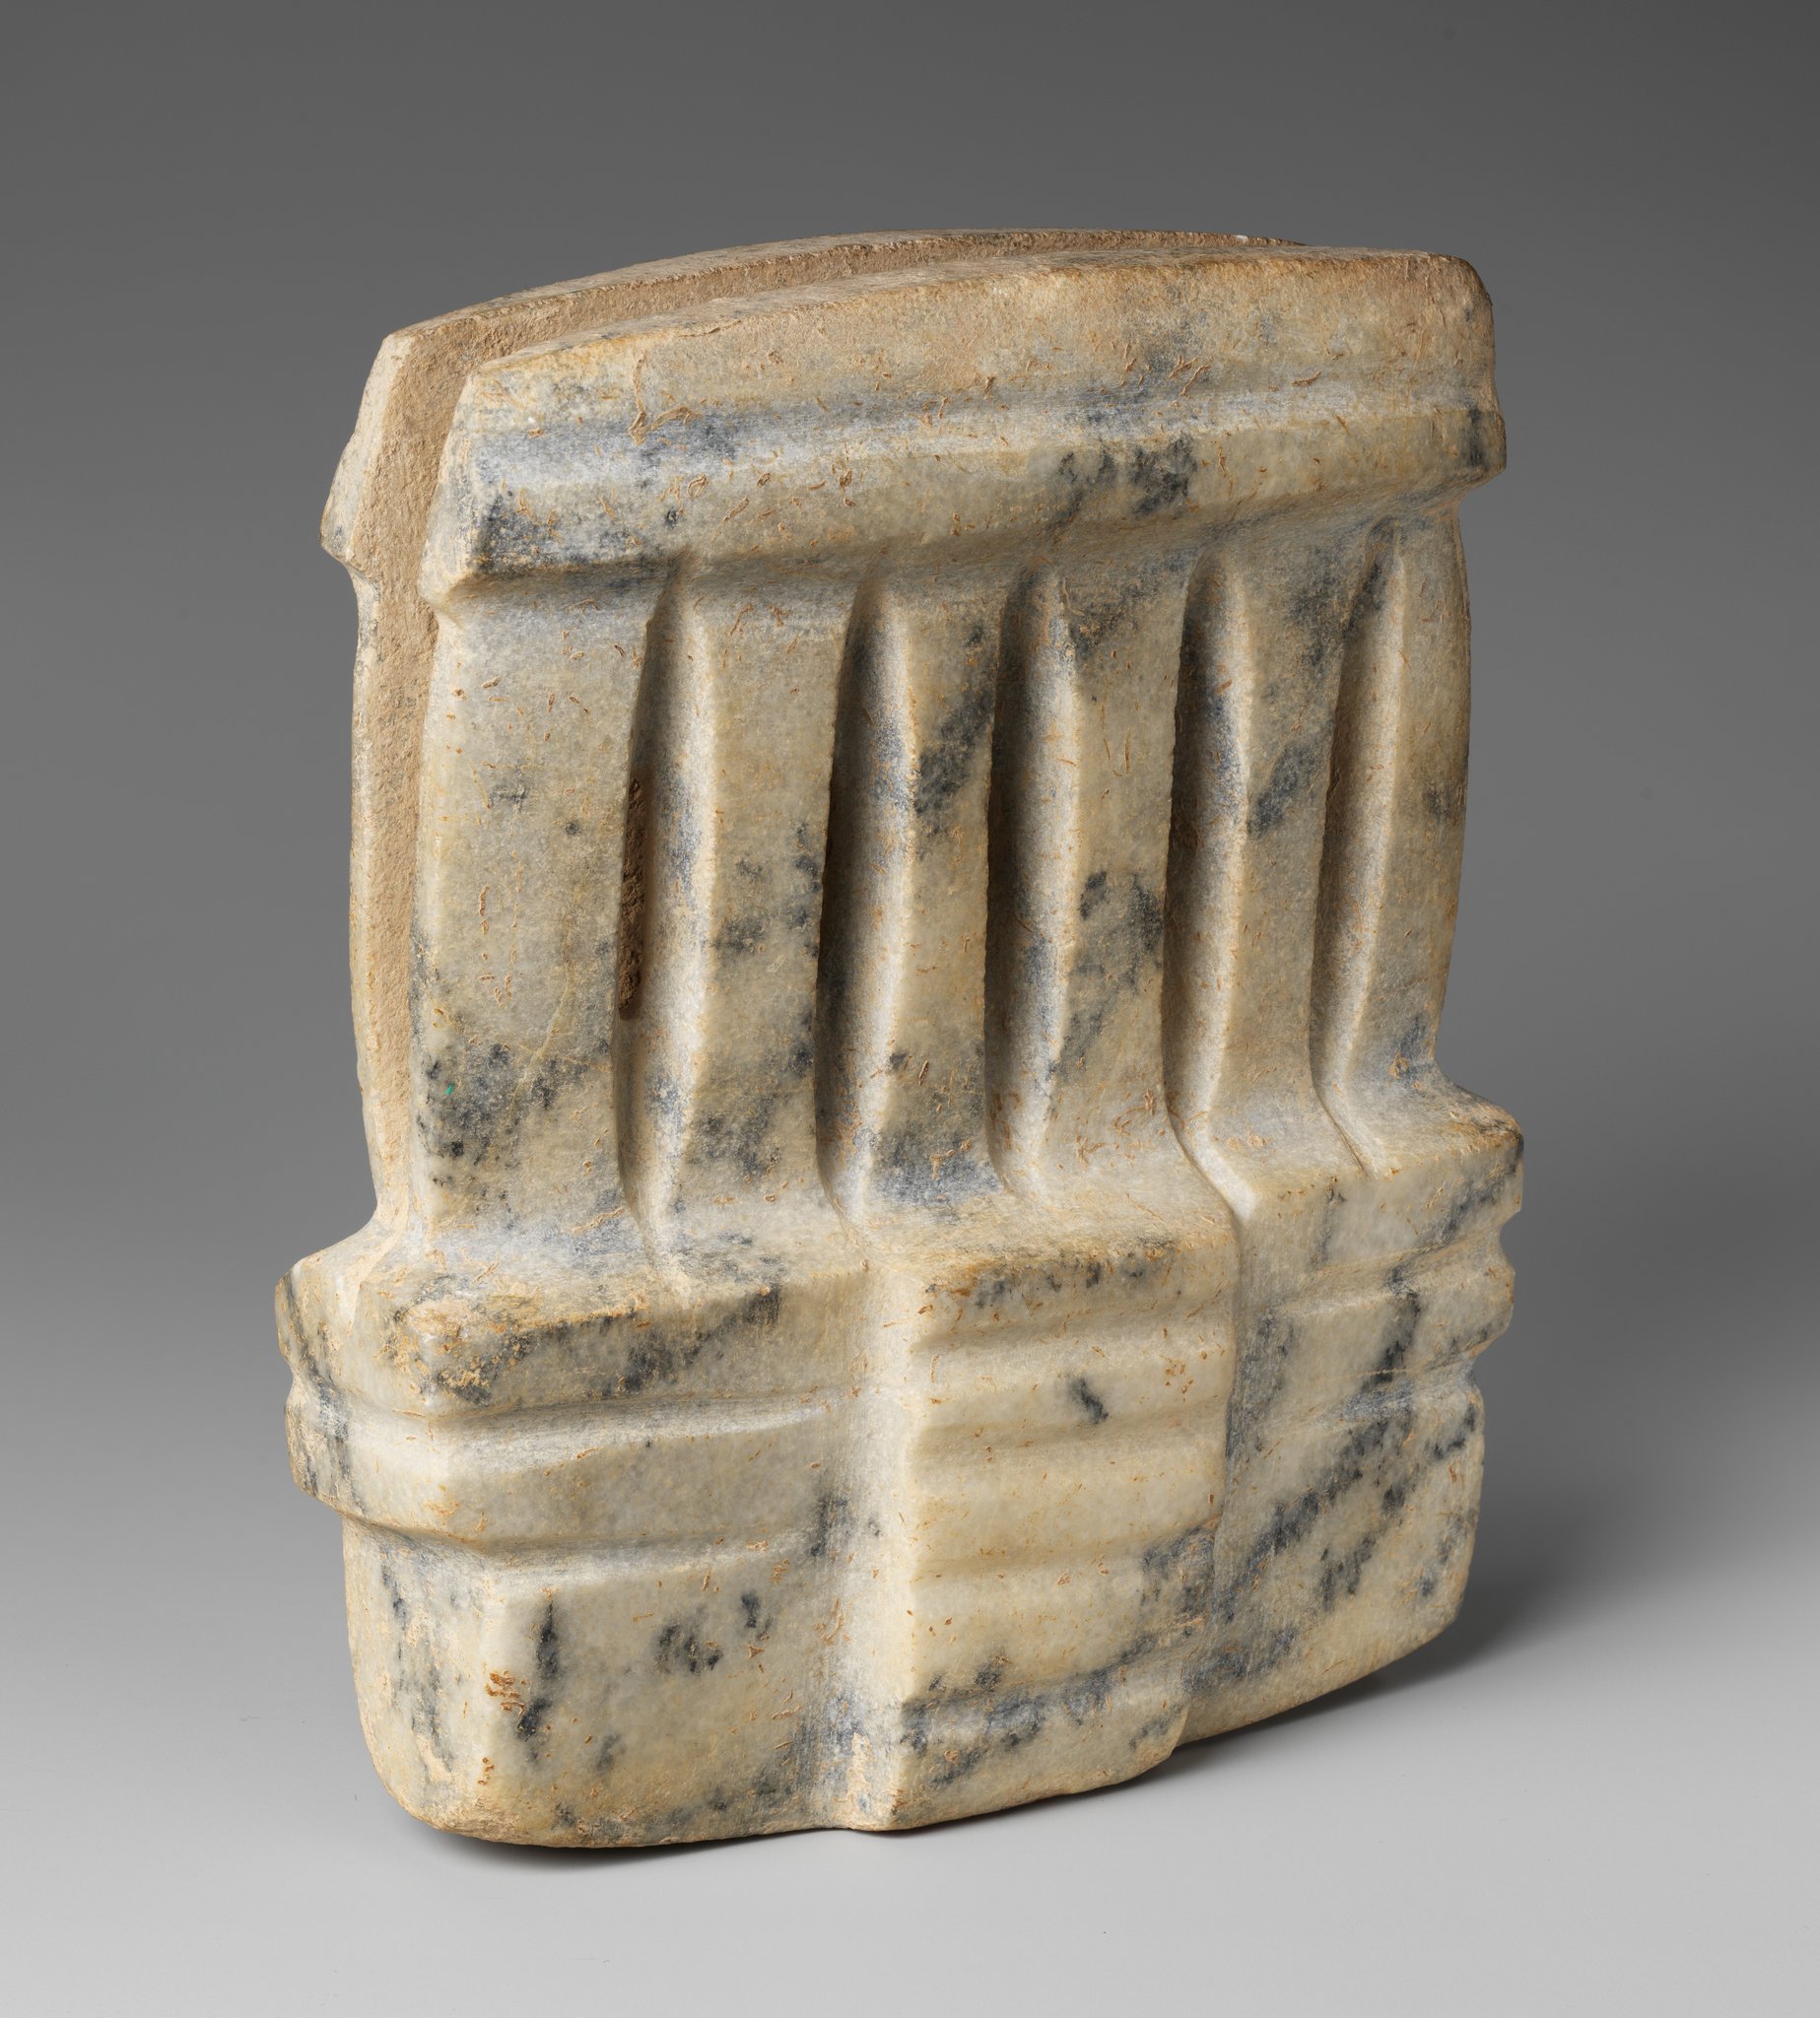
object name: architectural model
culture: mezcala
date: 1-800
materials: stone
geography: mexico